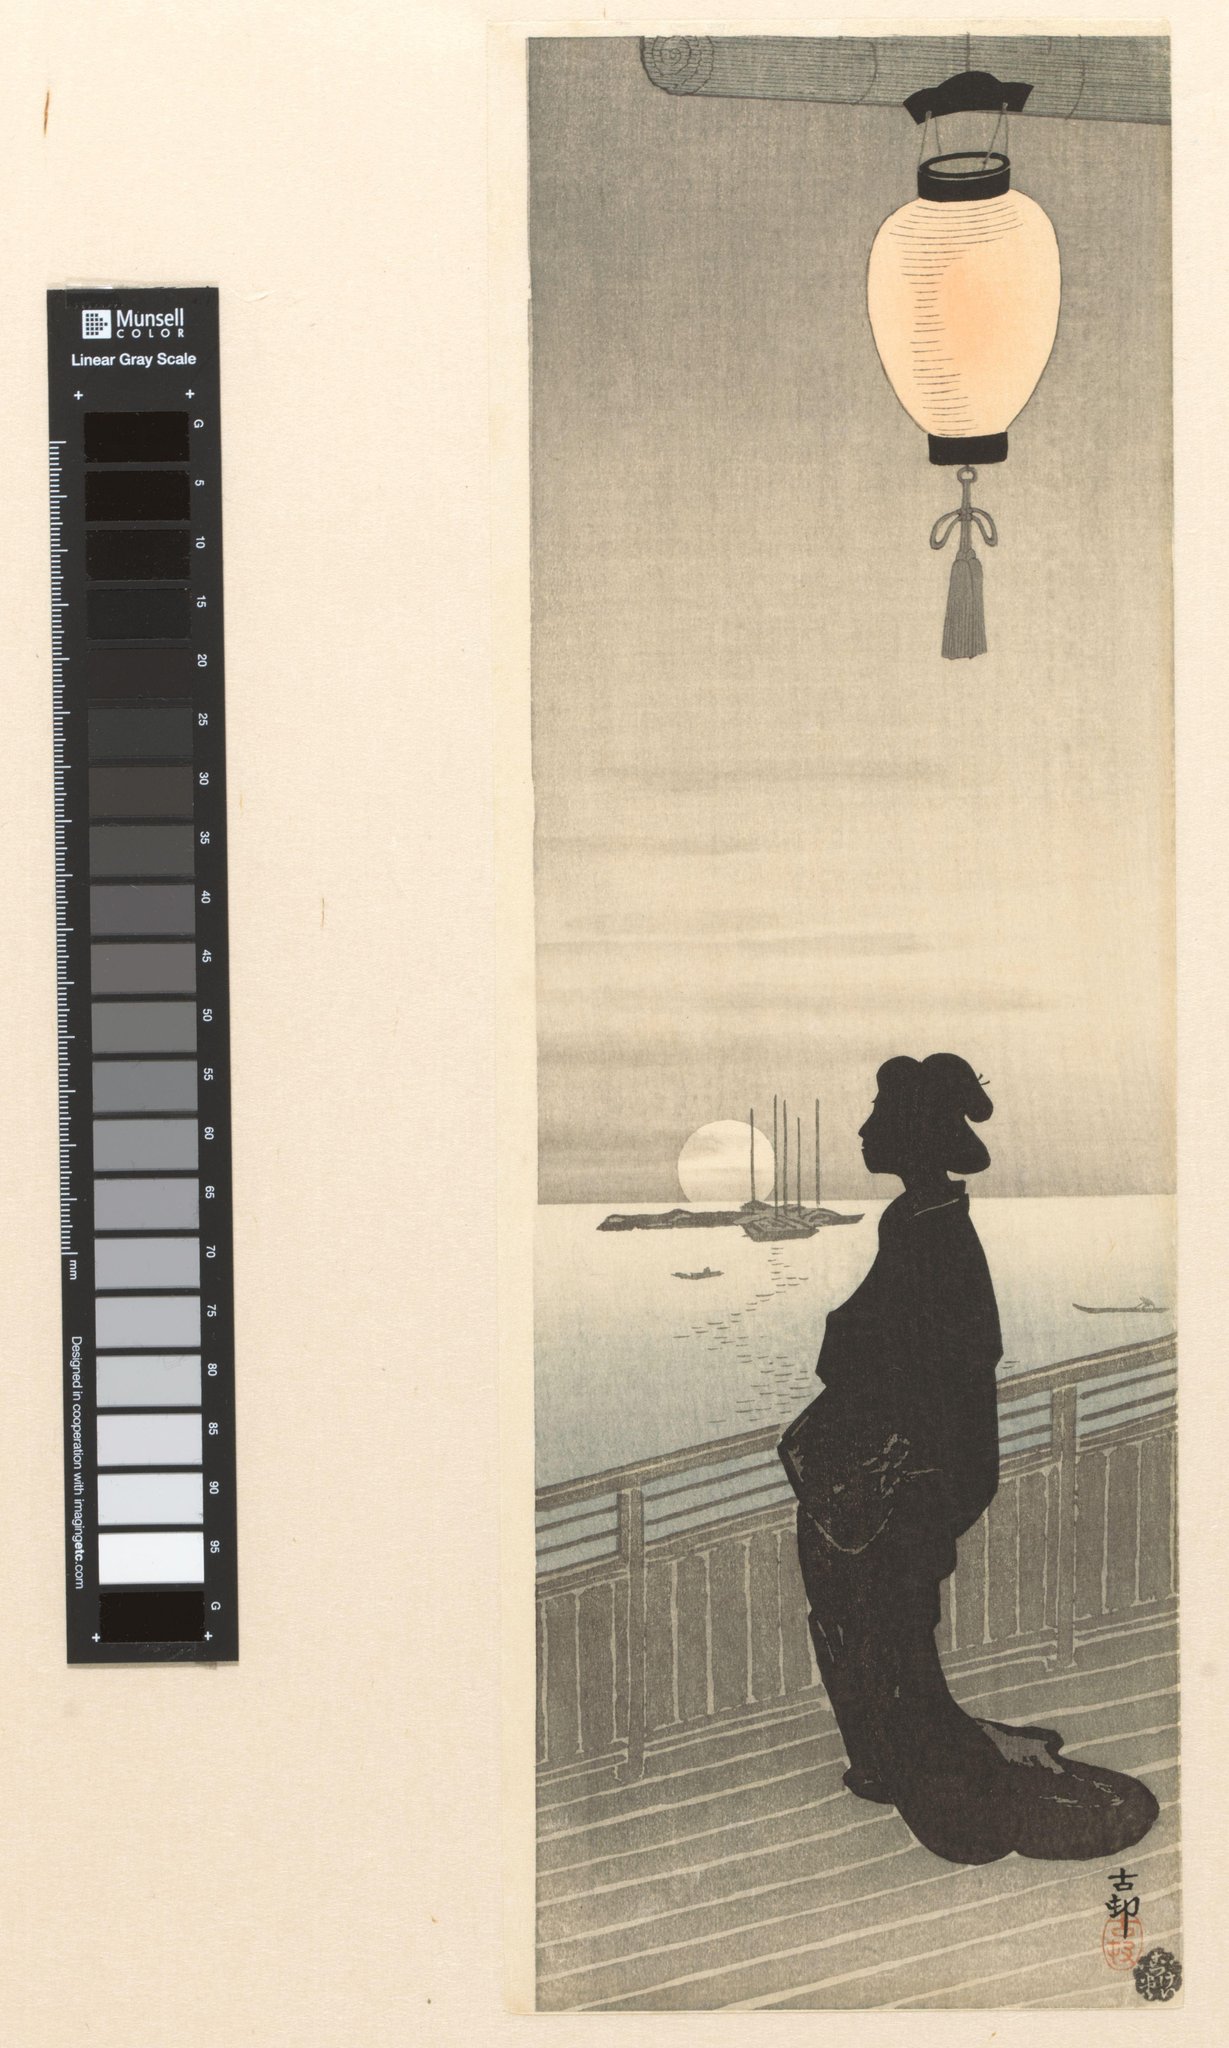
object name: print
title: Courtisane op veranda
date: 1900-1910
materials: paper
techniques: woodcut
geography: tokyo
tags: lantern, loggia, verandah, porch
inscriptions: collector's mark: Lugt 2228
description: Silhouet van Japanse dame in kimono; uitkijkend over water vanaf veranda, onder lantaarn.